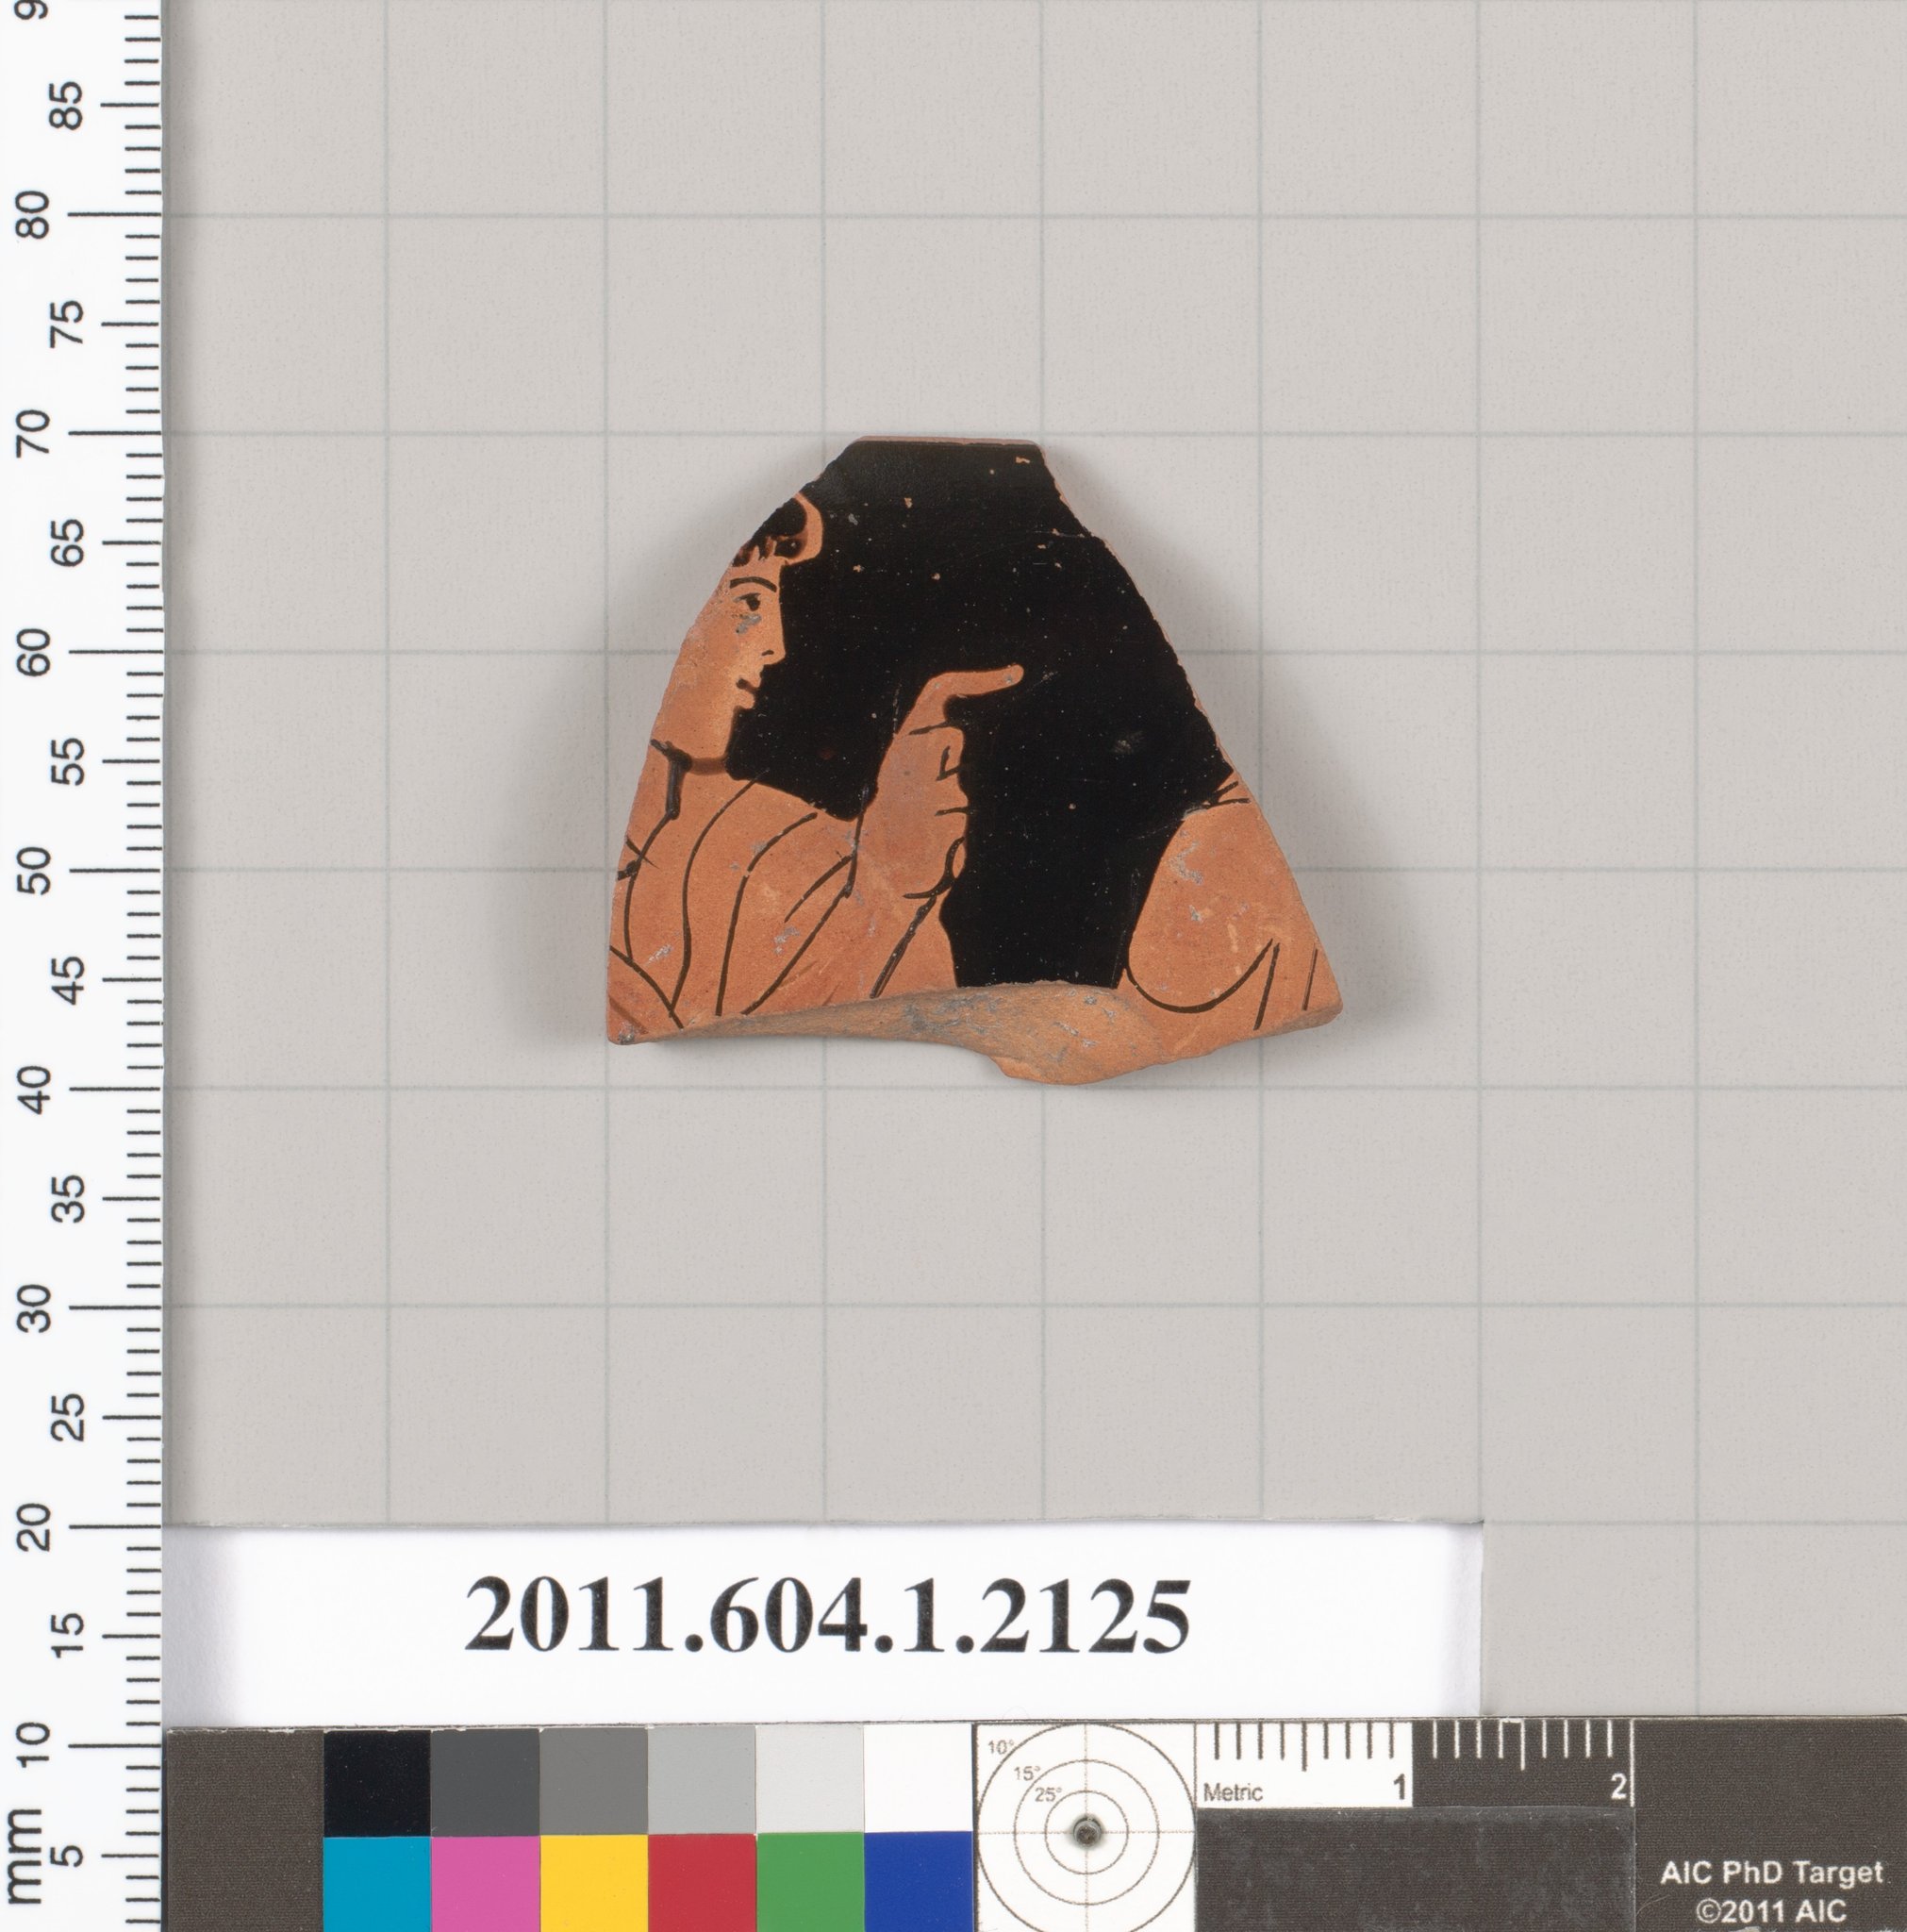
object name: kylix fragment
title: Terracotta rim fragment of a kylix (drinking cup)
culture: greek, attic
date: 467-435 BCE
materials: terracotta